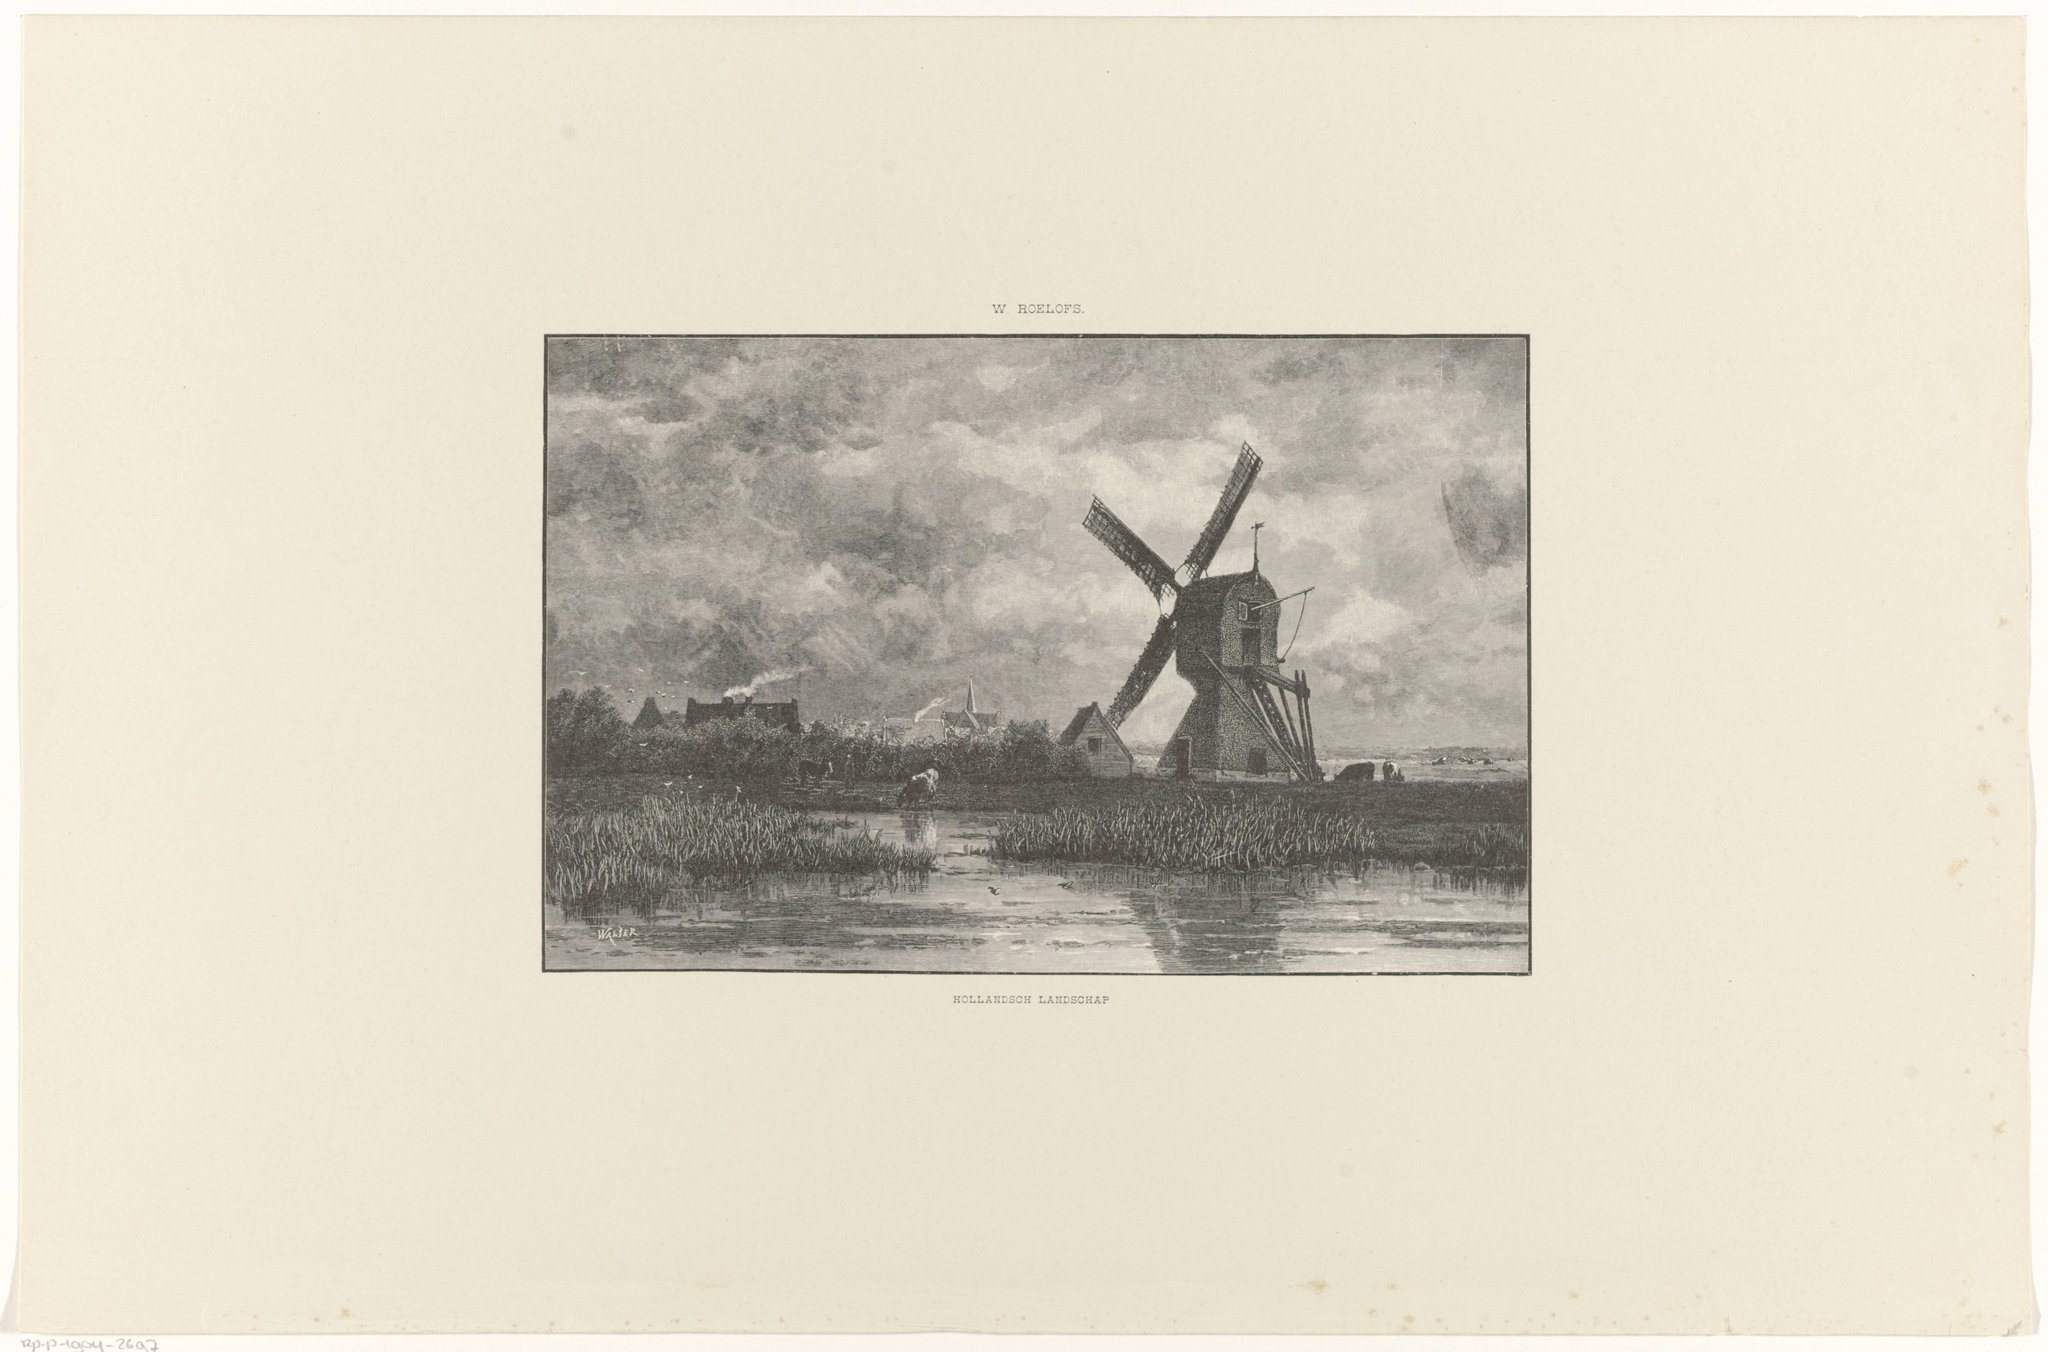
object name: print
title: Hollandsch landschap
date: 1849-1895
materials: paper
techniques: engraving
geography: netherlands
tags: cow, windmill in landscape, water meadows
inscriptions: collector's mark: Lugt 2228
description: Landschap met een molen en koeien in de wei.